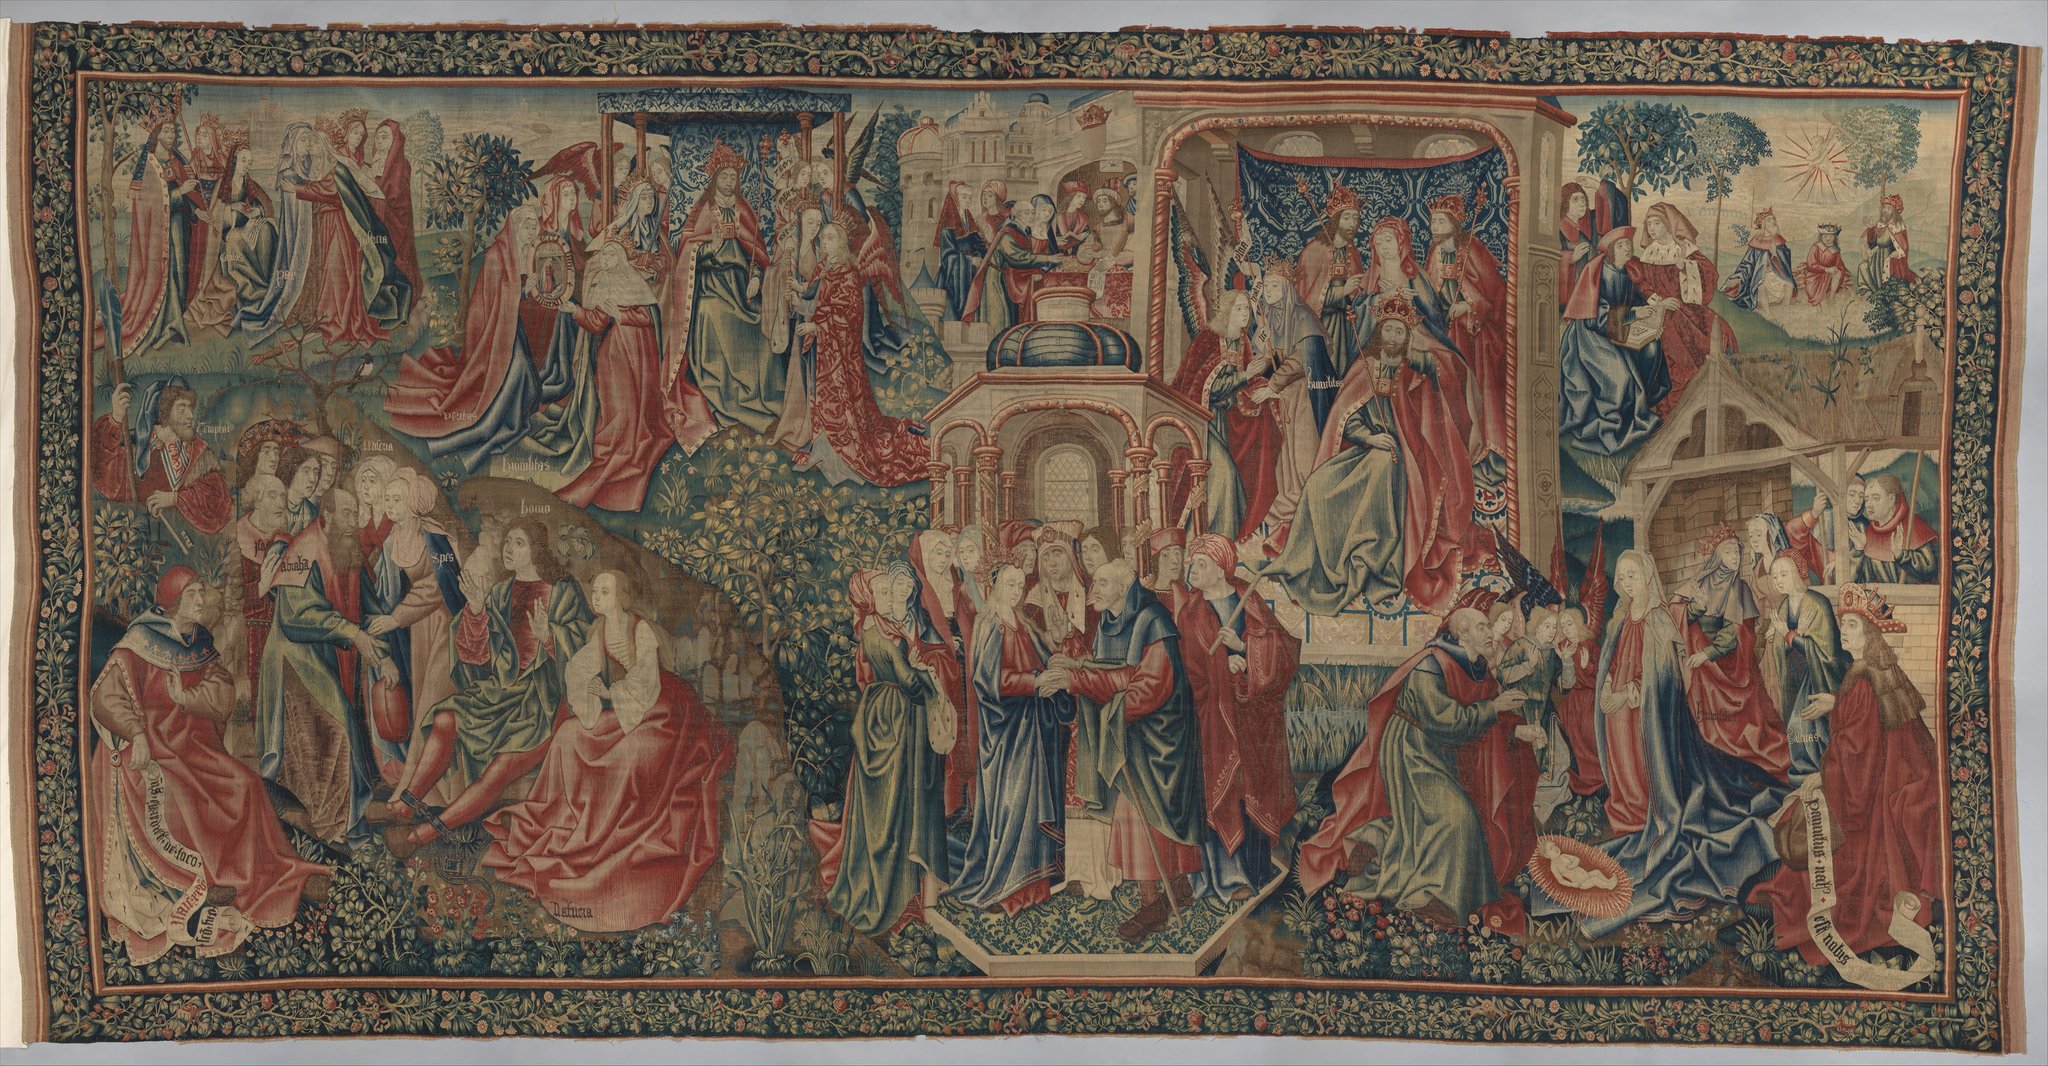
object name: tapestry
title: Christ Is Born as Man's Redeemer (Episode from the Story of the Redemption of Man)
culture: south netherlandish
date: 1500-1520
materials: silk, wool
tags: angels,saint joseph,virgin mary,jesus,annunciation,nativity,god the father